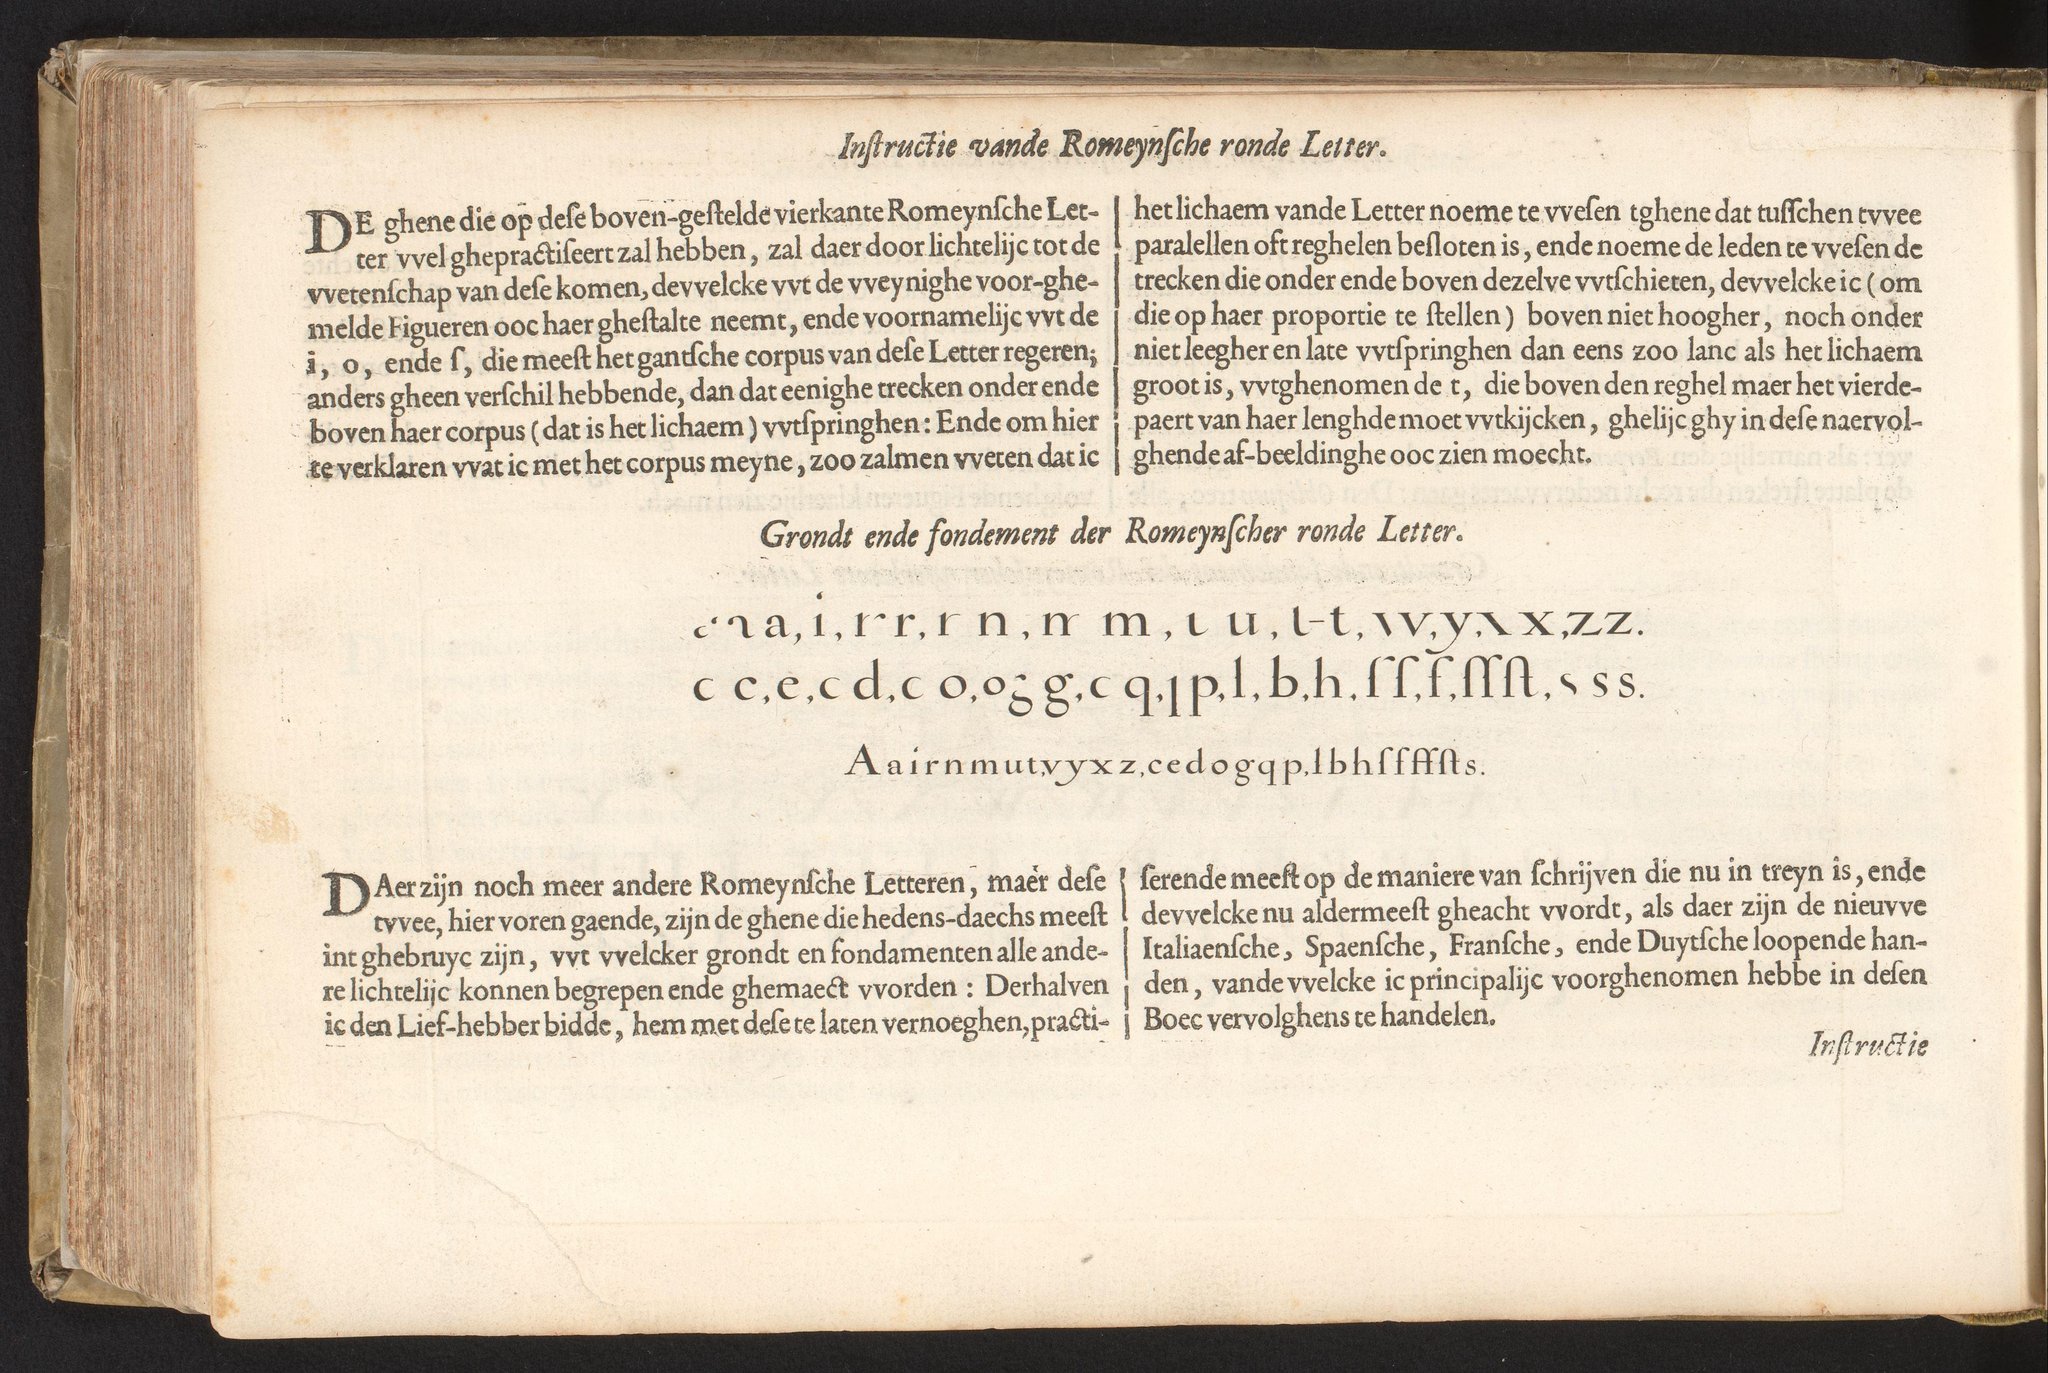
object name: print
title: Beschrijving en schrijfvoorbeeld van de Romeinse ronde letter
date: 1605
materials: paper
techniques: engraving, letterpress printing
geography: haarlem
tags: calligraphy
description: Folio B2v met een schrijfvoorbeeld getiteld: Grondt ende fondament der Romeynscher ronde letter. Het blad maakt deel uit van een album.